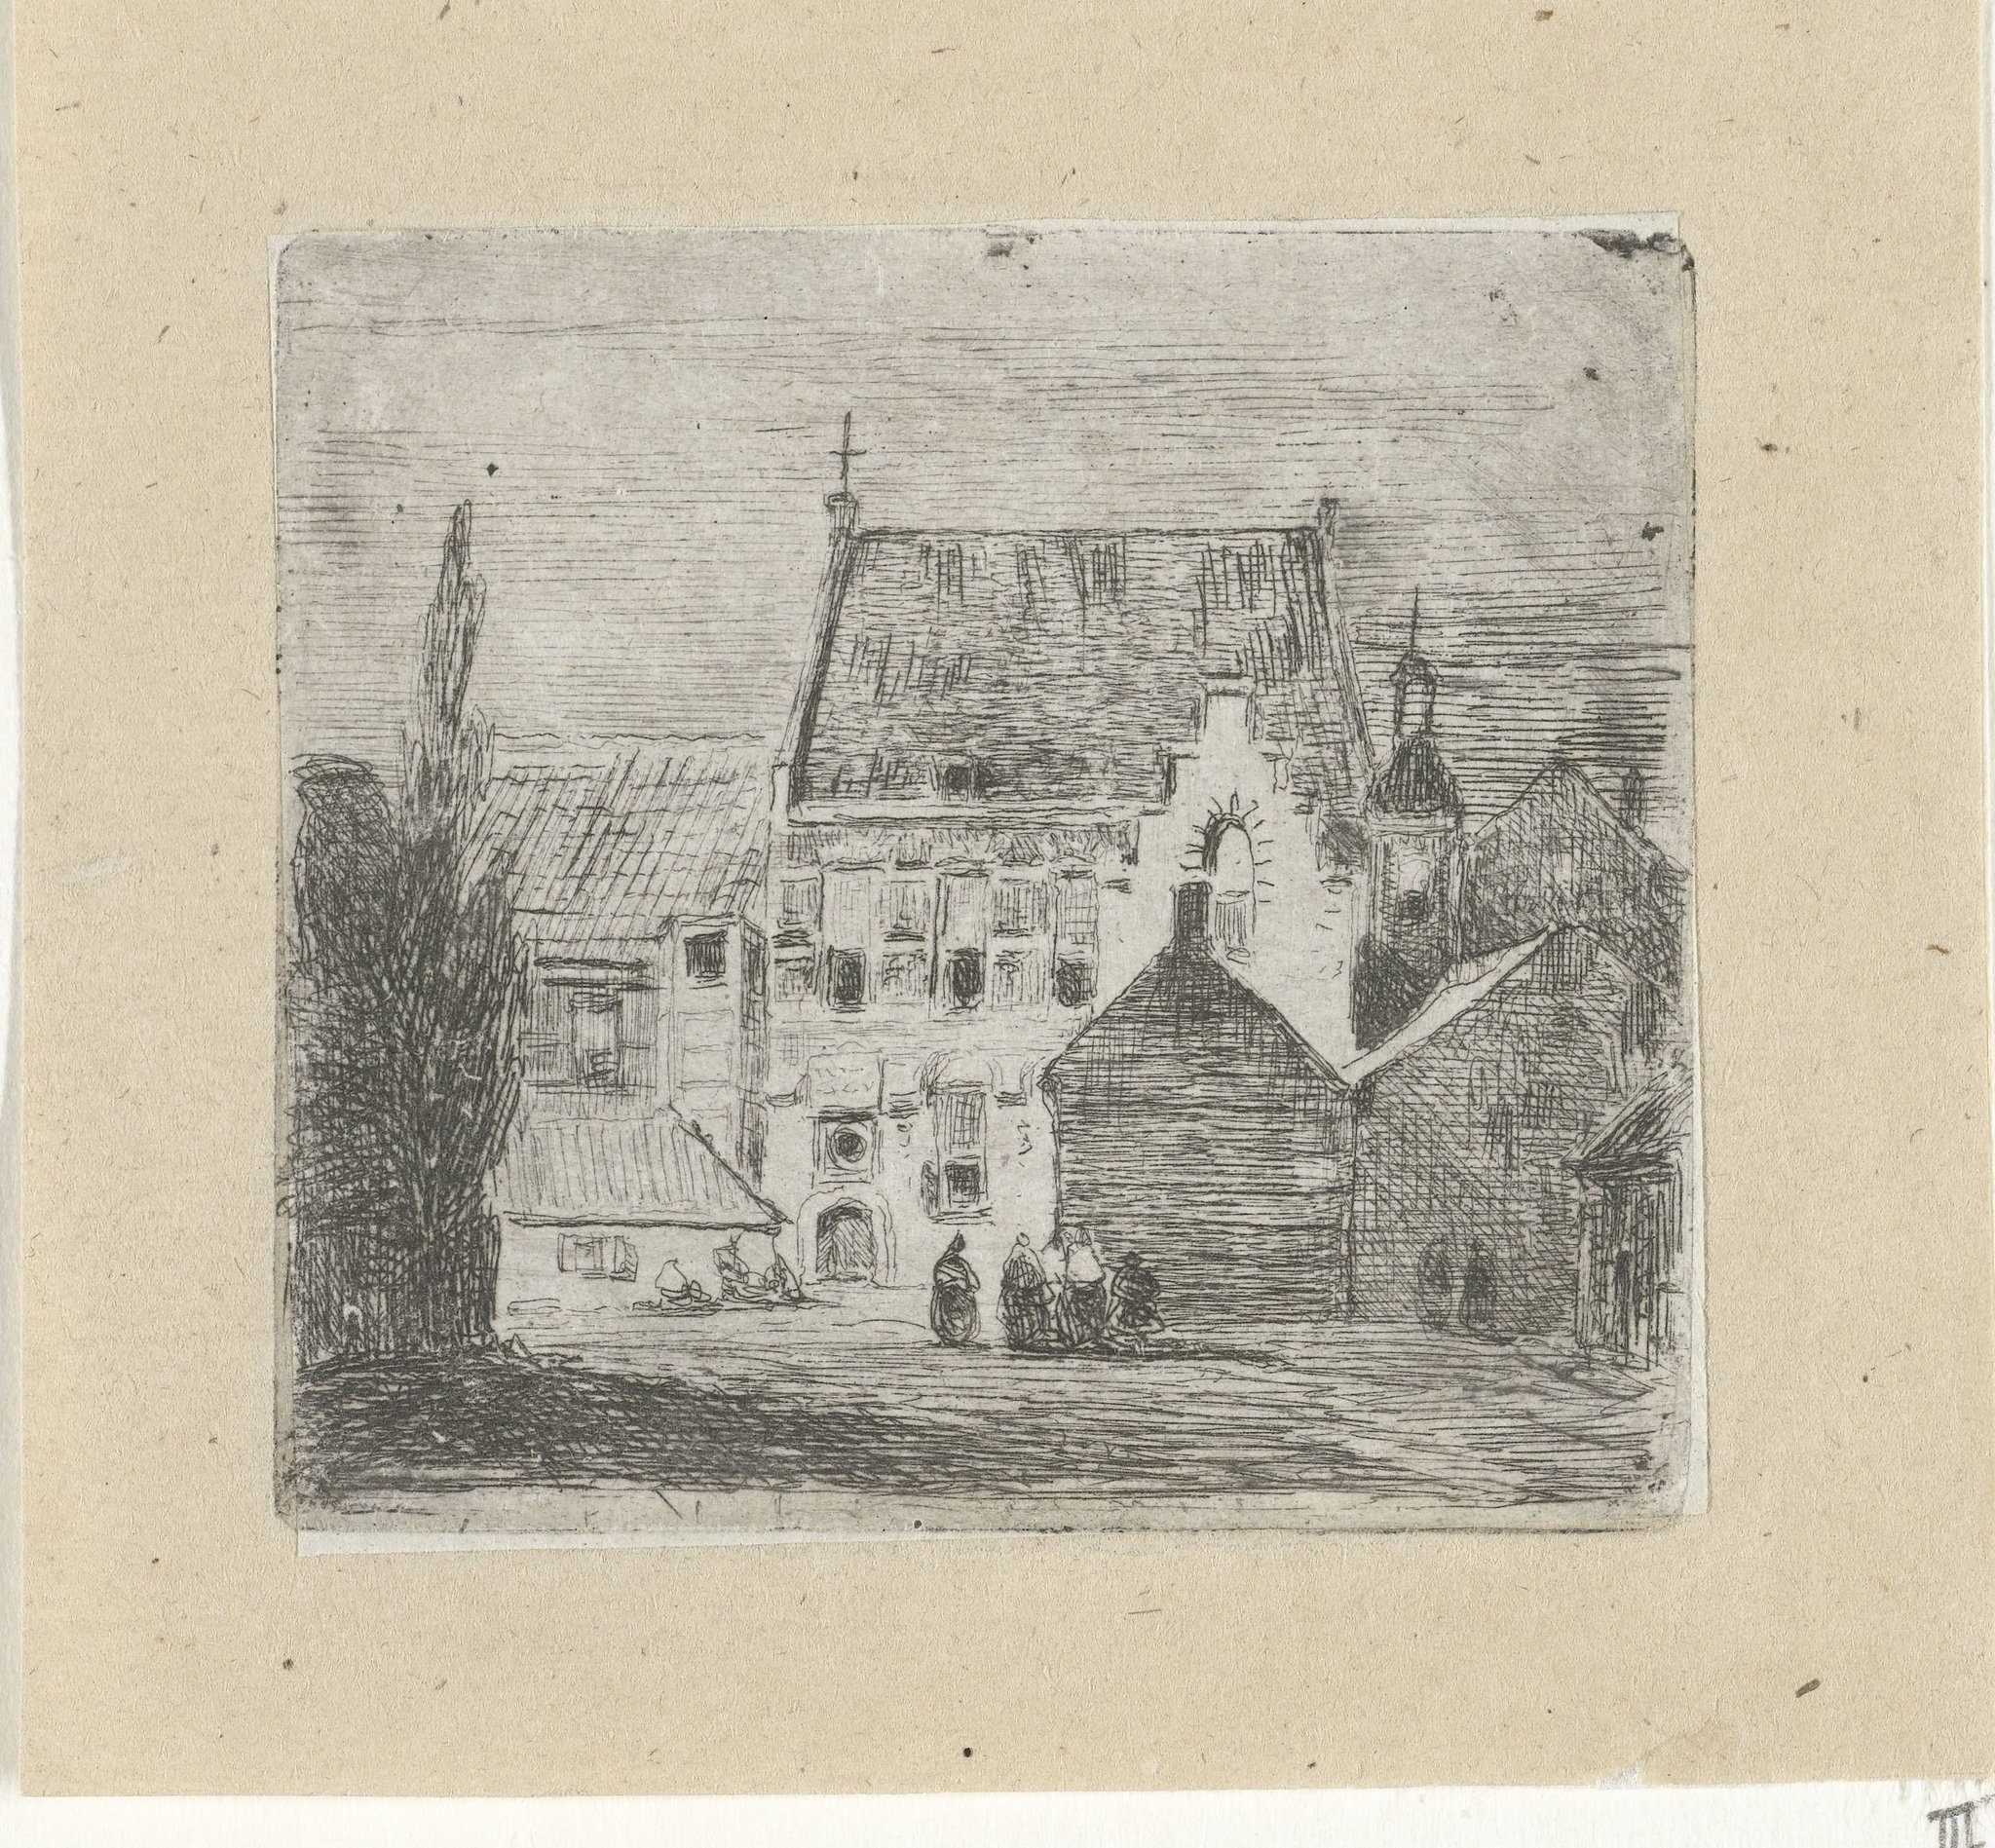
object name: print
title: Stadsgezicht met converserende vrouwen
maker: lambertus hardenberg (1822-1900)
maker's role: draughtsman, painter, print maker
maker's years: 1822-1900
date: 1837-1900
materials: paper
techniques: etching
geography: the hague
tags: city-view in general; 'veduta' (+ city(-scape) with figures, staffage)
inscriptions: collector's mark: Lugt 2228